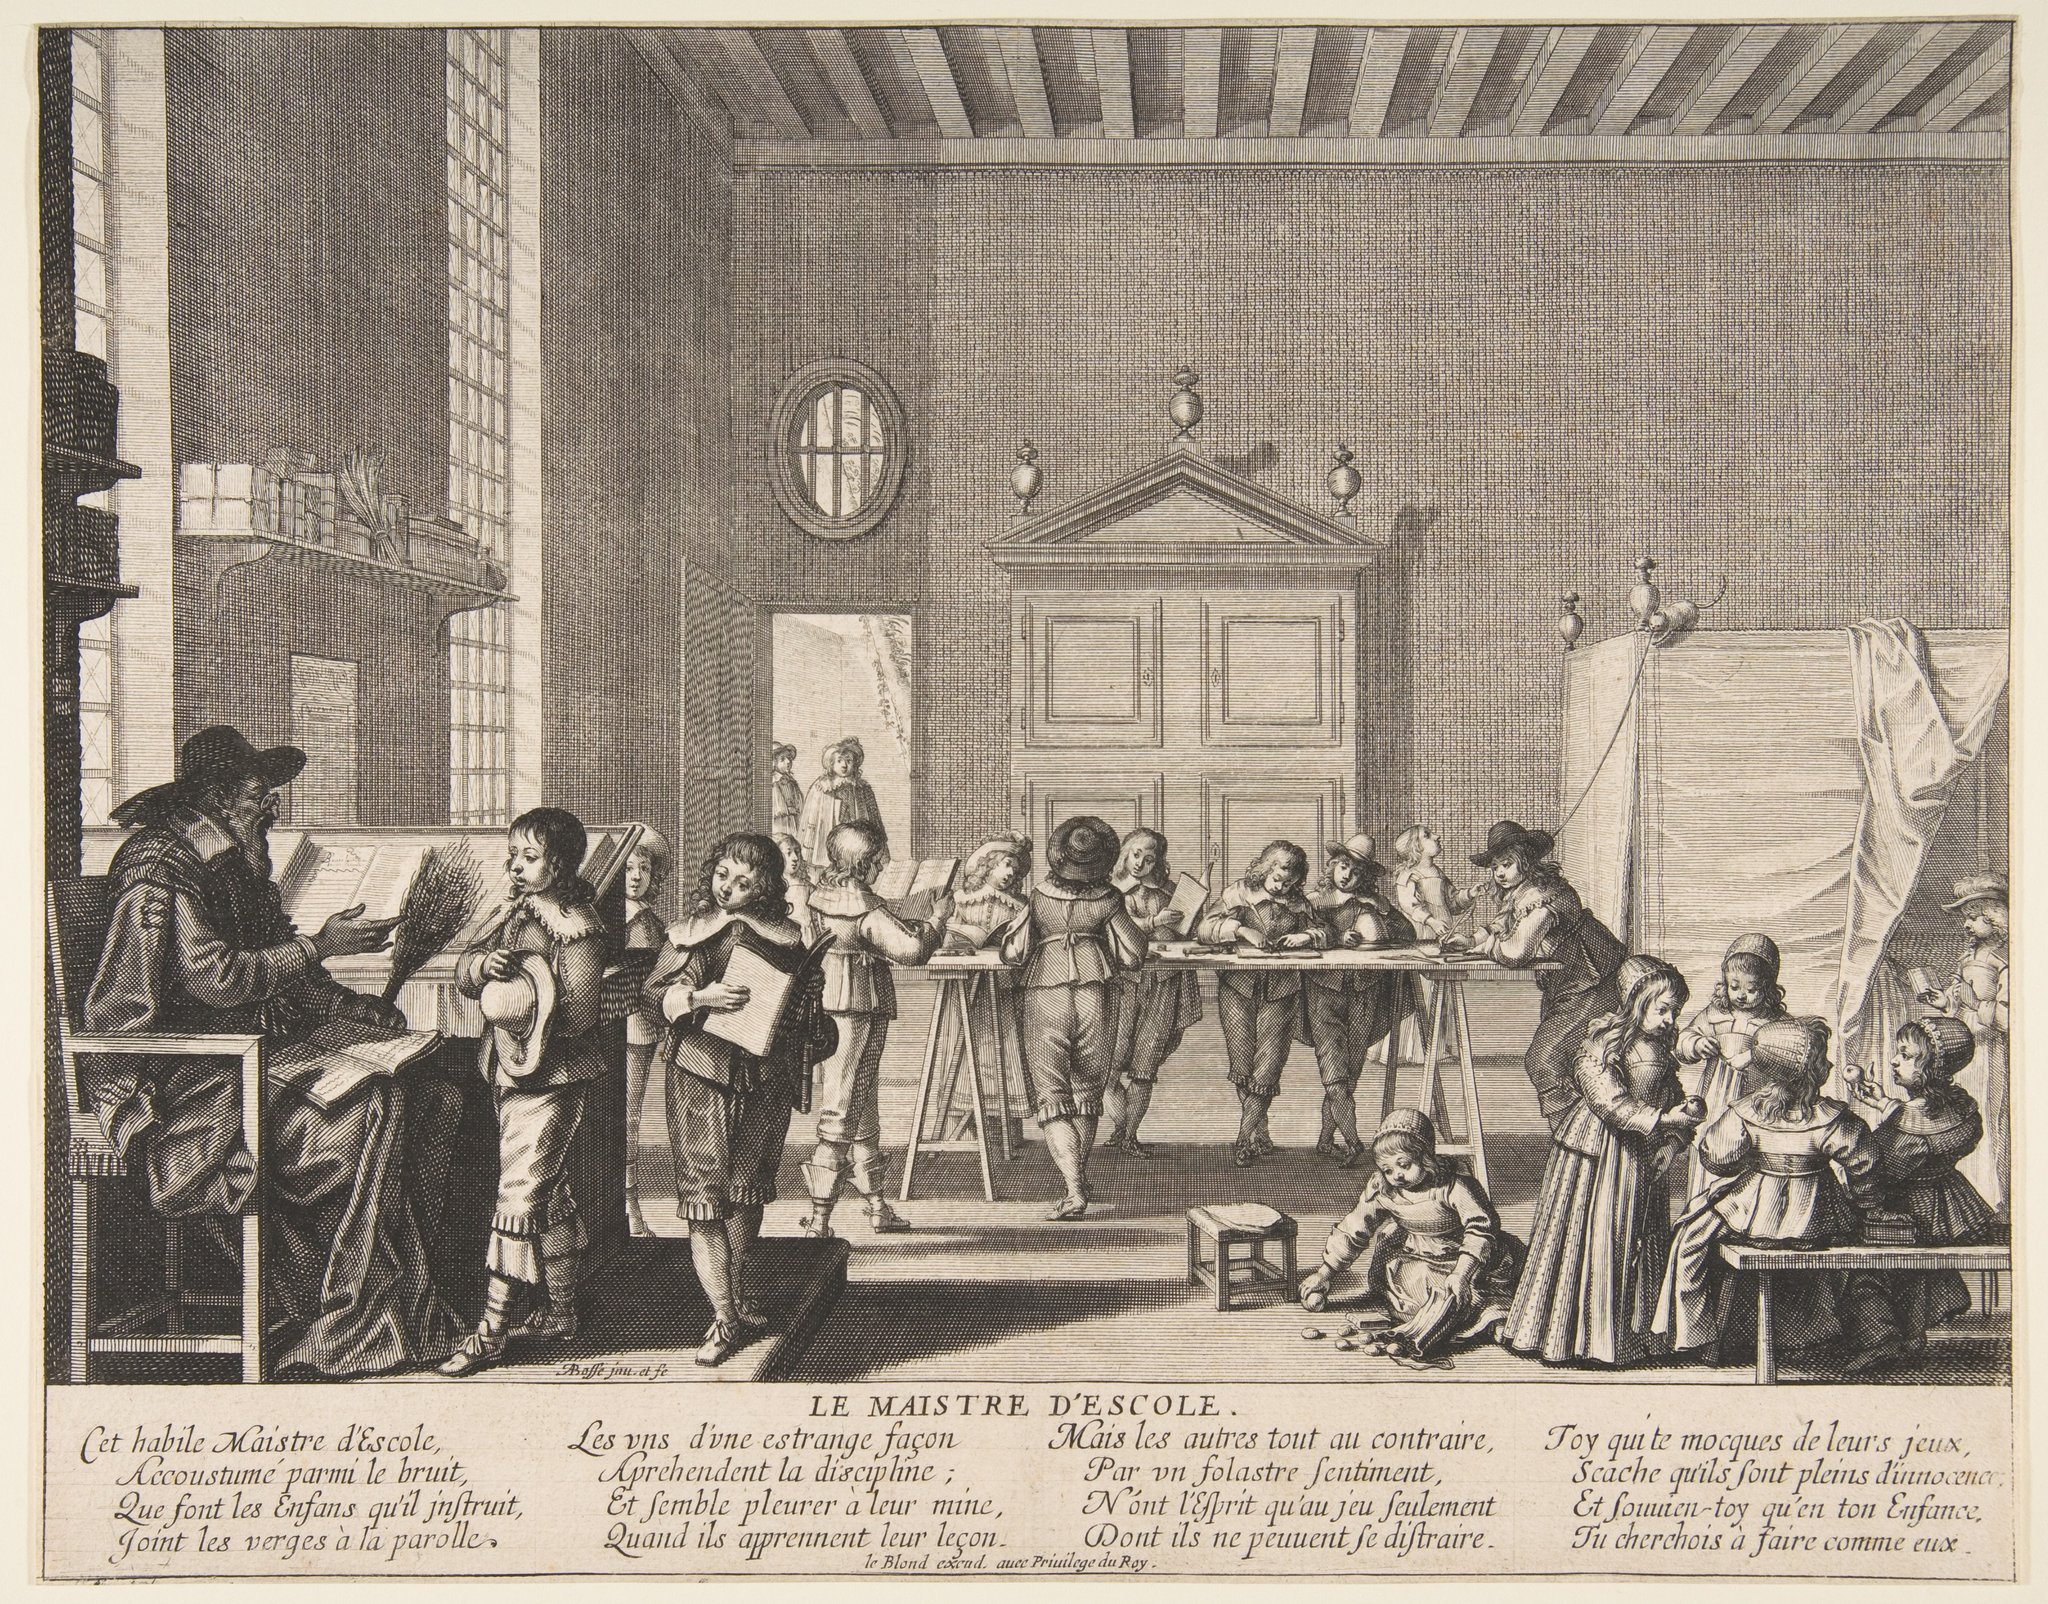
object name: print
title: The School Master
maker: abraham bosse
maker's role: artist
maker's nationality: french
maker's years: 1602-1676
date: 1635-1638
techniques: etching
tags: schools,interiors,students,teachers